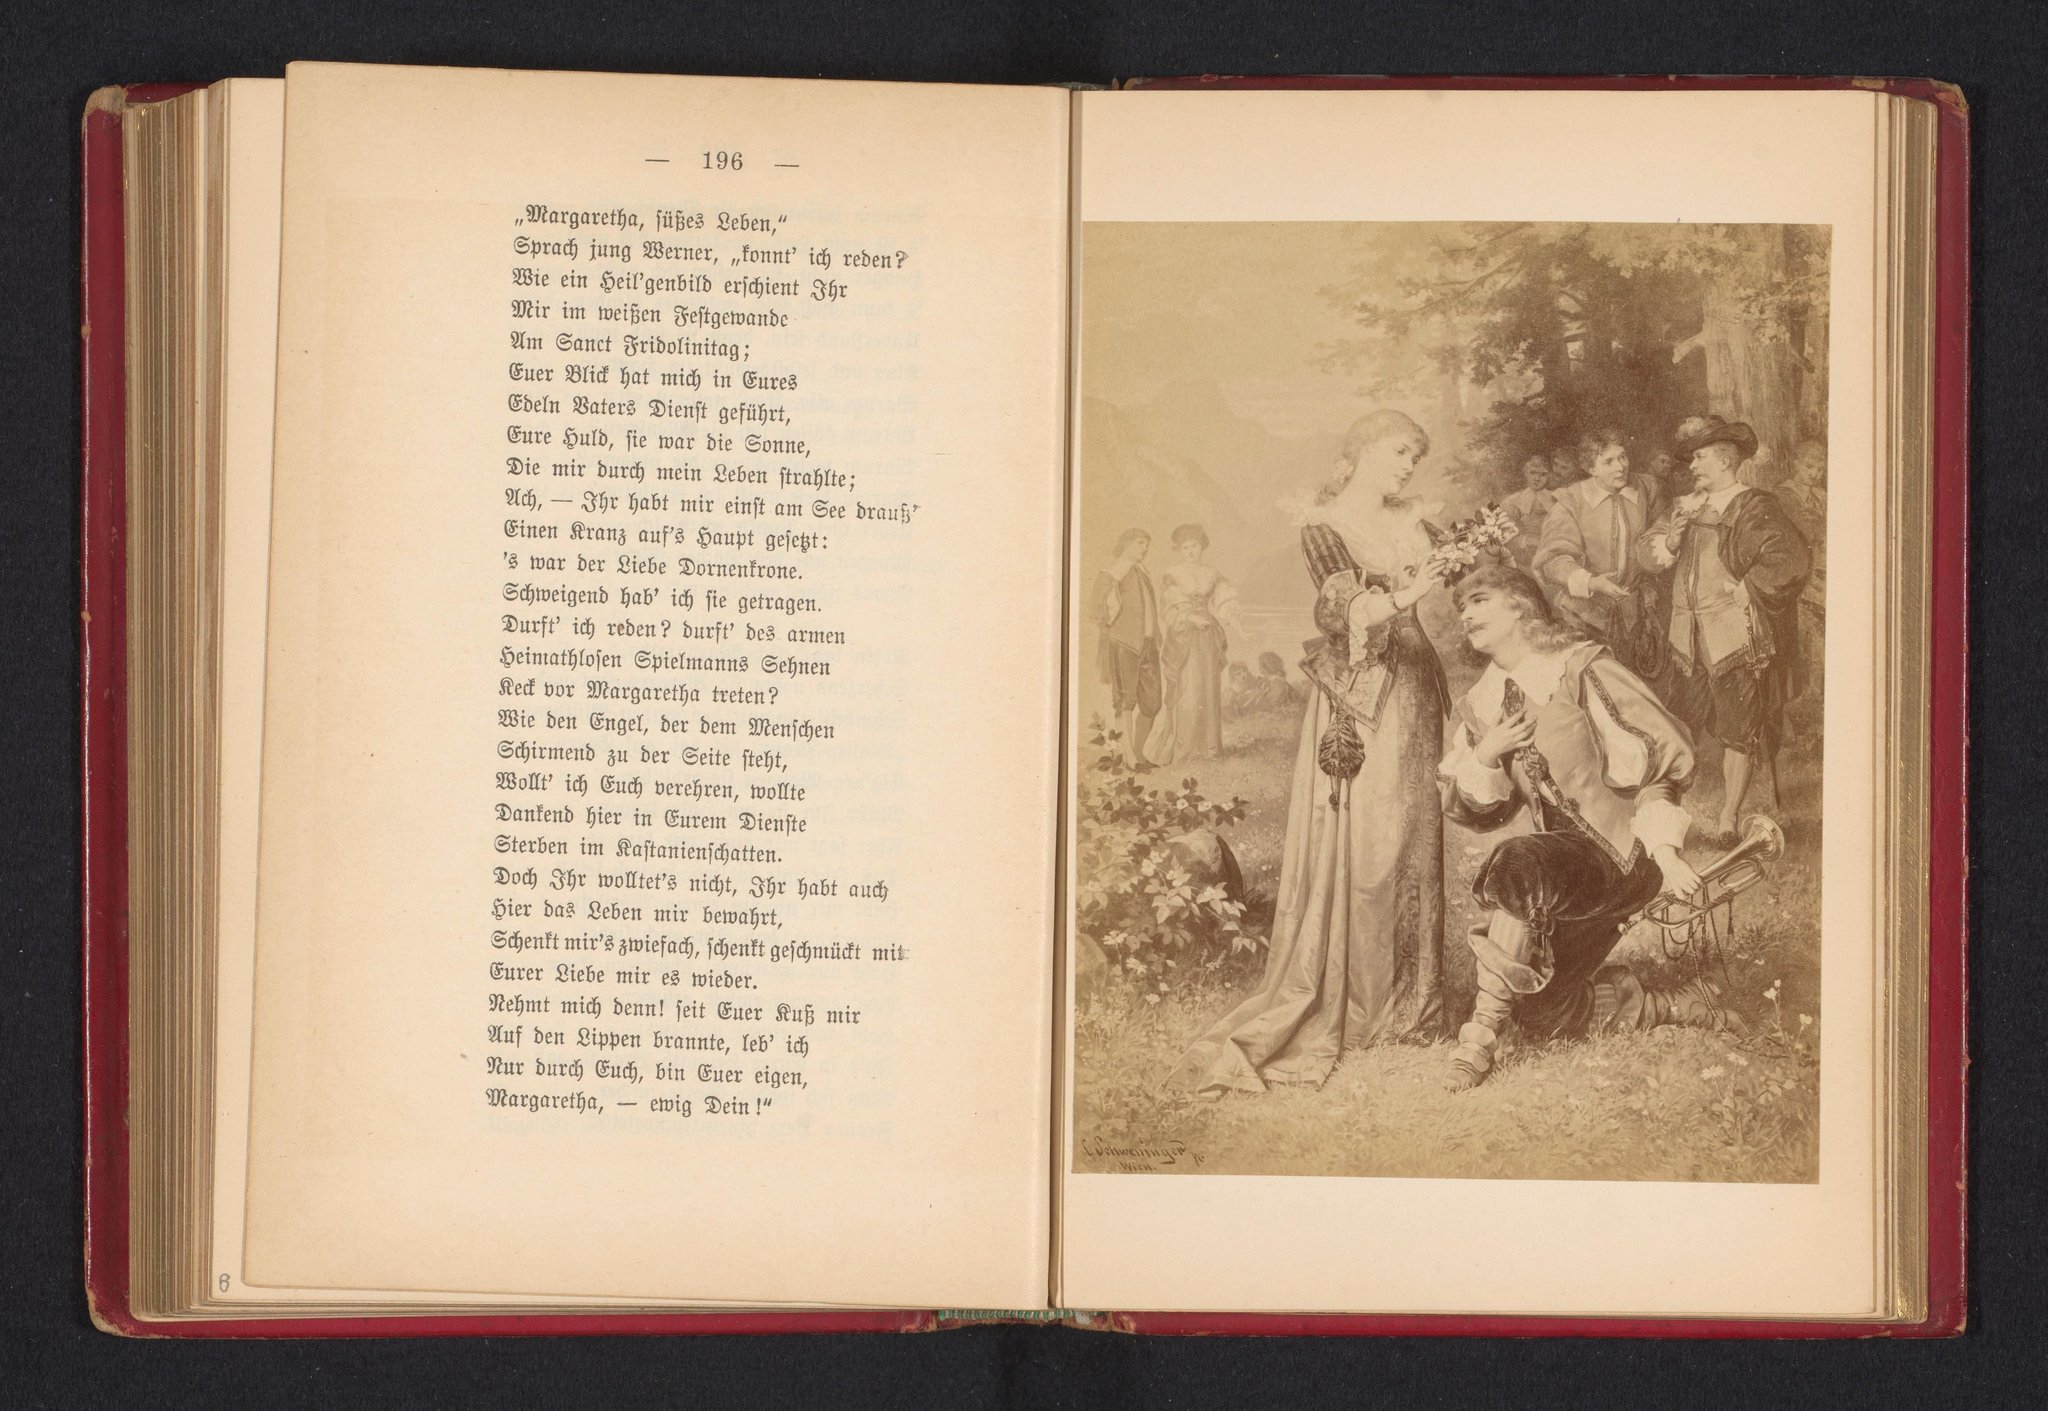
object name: photograph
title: Fotoreproductie van een schilderij van een scene uit Der Trompeter von Säkkingen, voorstellende Maria die de trompetter een bloemenkrans op doet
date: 1880-1890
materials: photographic support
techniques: albumen print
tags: garland, wreath, picture, painting